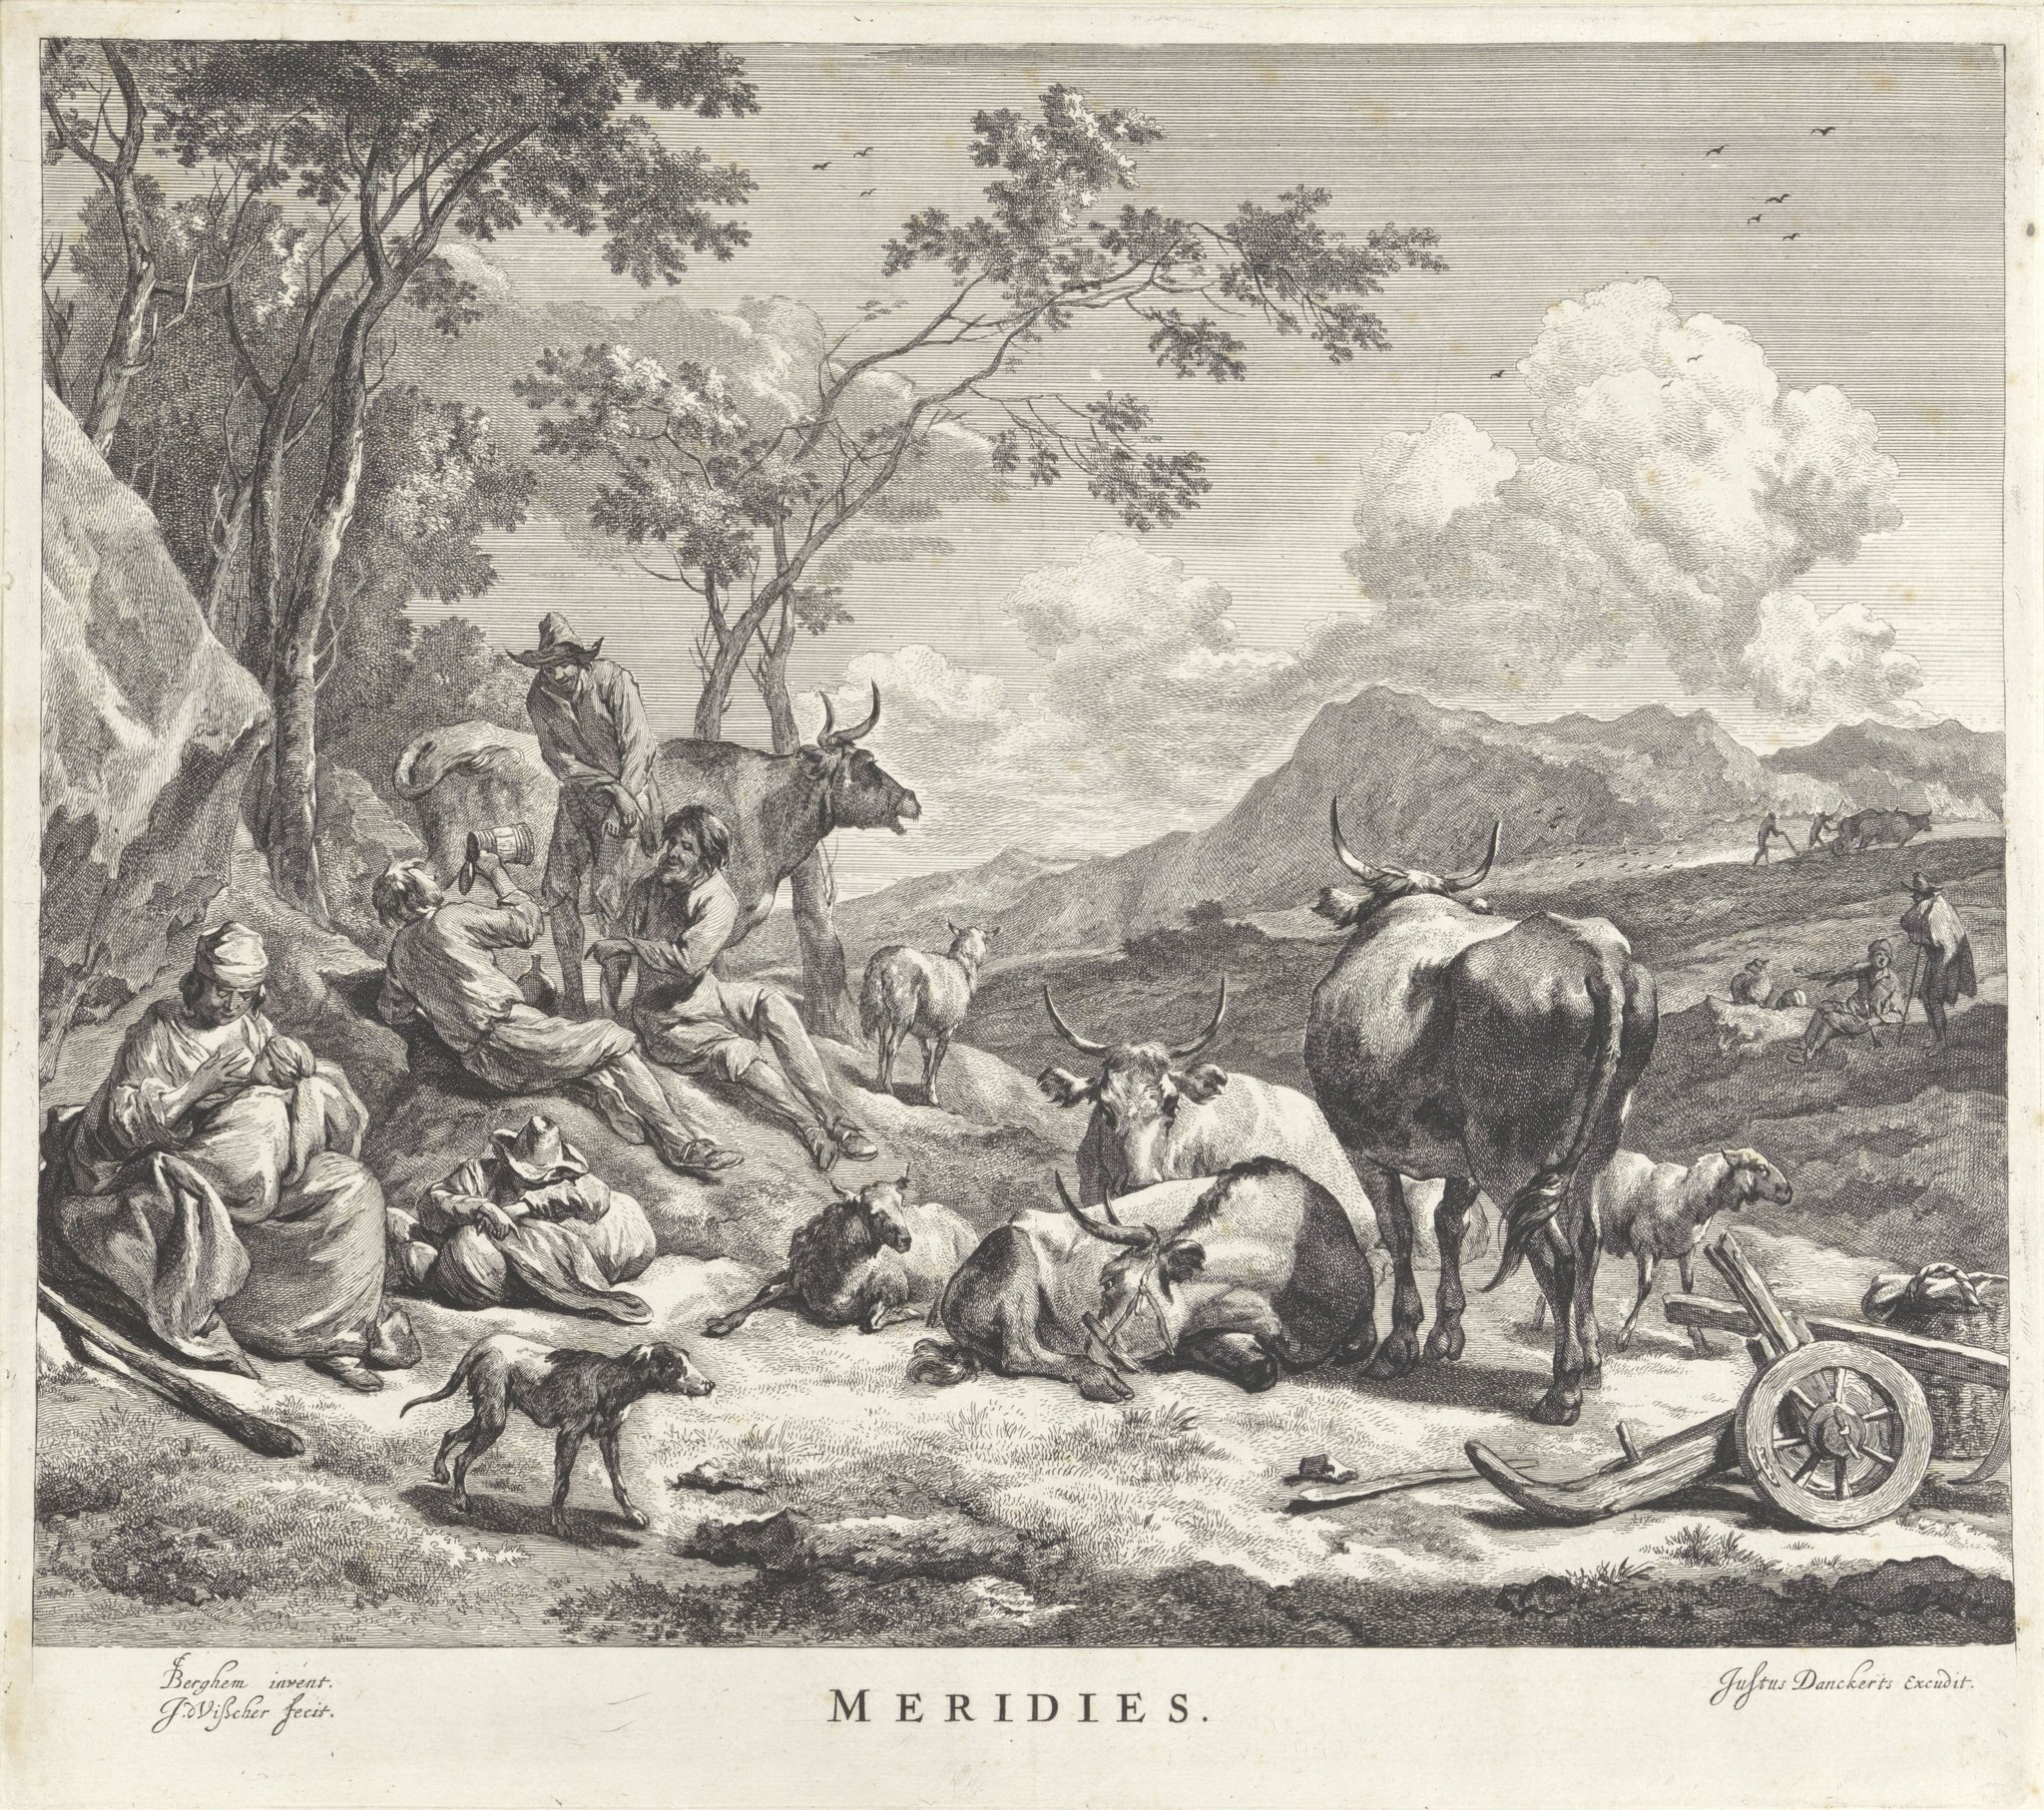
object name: print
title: Middag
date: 1645-1701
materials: paper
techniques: engraving, etching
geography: amsterdam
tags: landscapes, herding, herdsman, herdswoman, shepherd, shepherdess, cowherd, etc., afternoon, resting - bb - out of doors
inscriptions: collector's mark: Lugt 240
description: Gezicht op een heuvelachtig landschap met herders en hun vee, bij middag. De herders genieten van hun middagpauze, enkele eten en drinken en een andere herder knapt een uiltje. Op de voorgrond voedt een herderin haar baby.